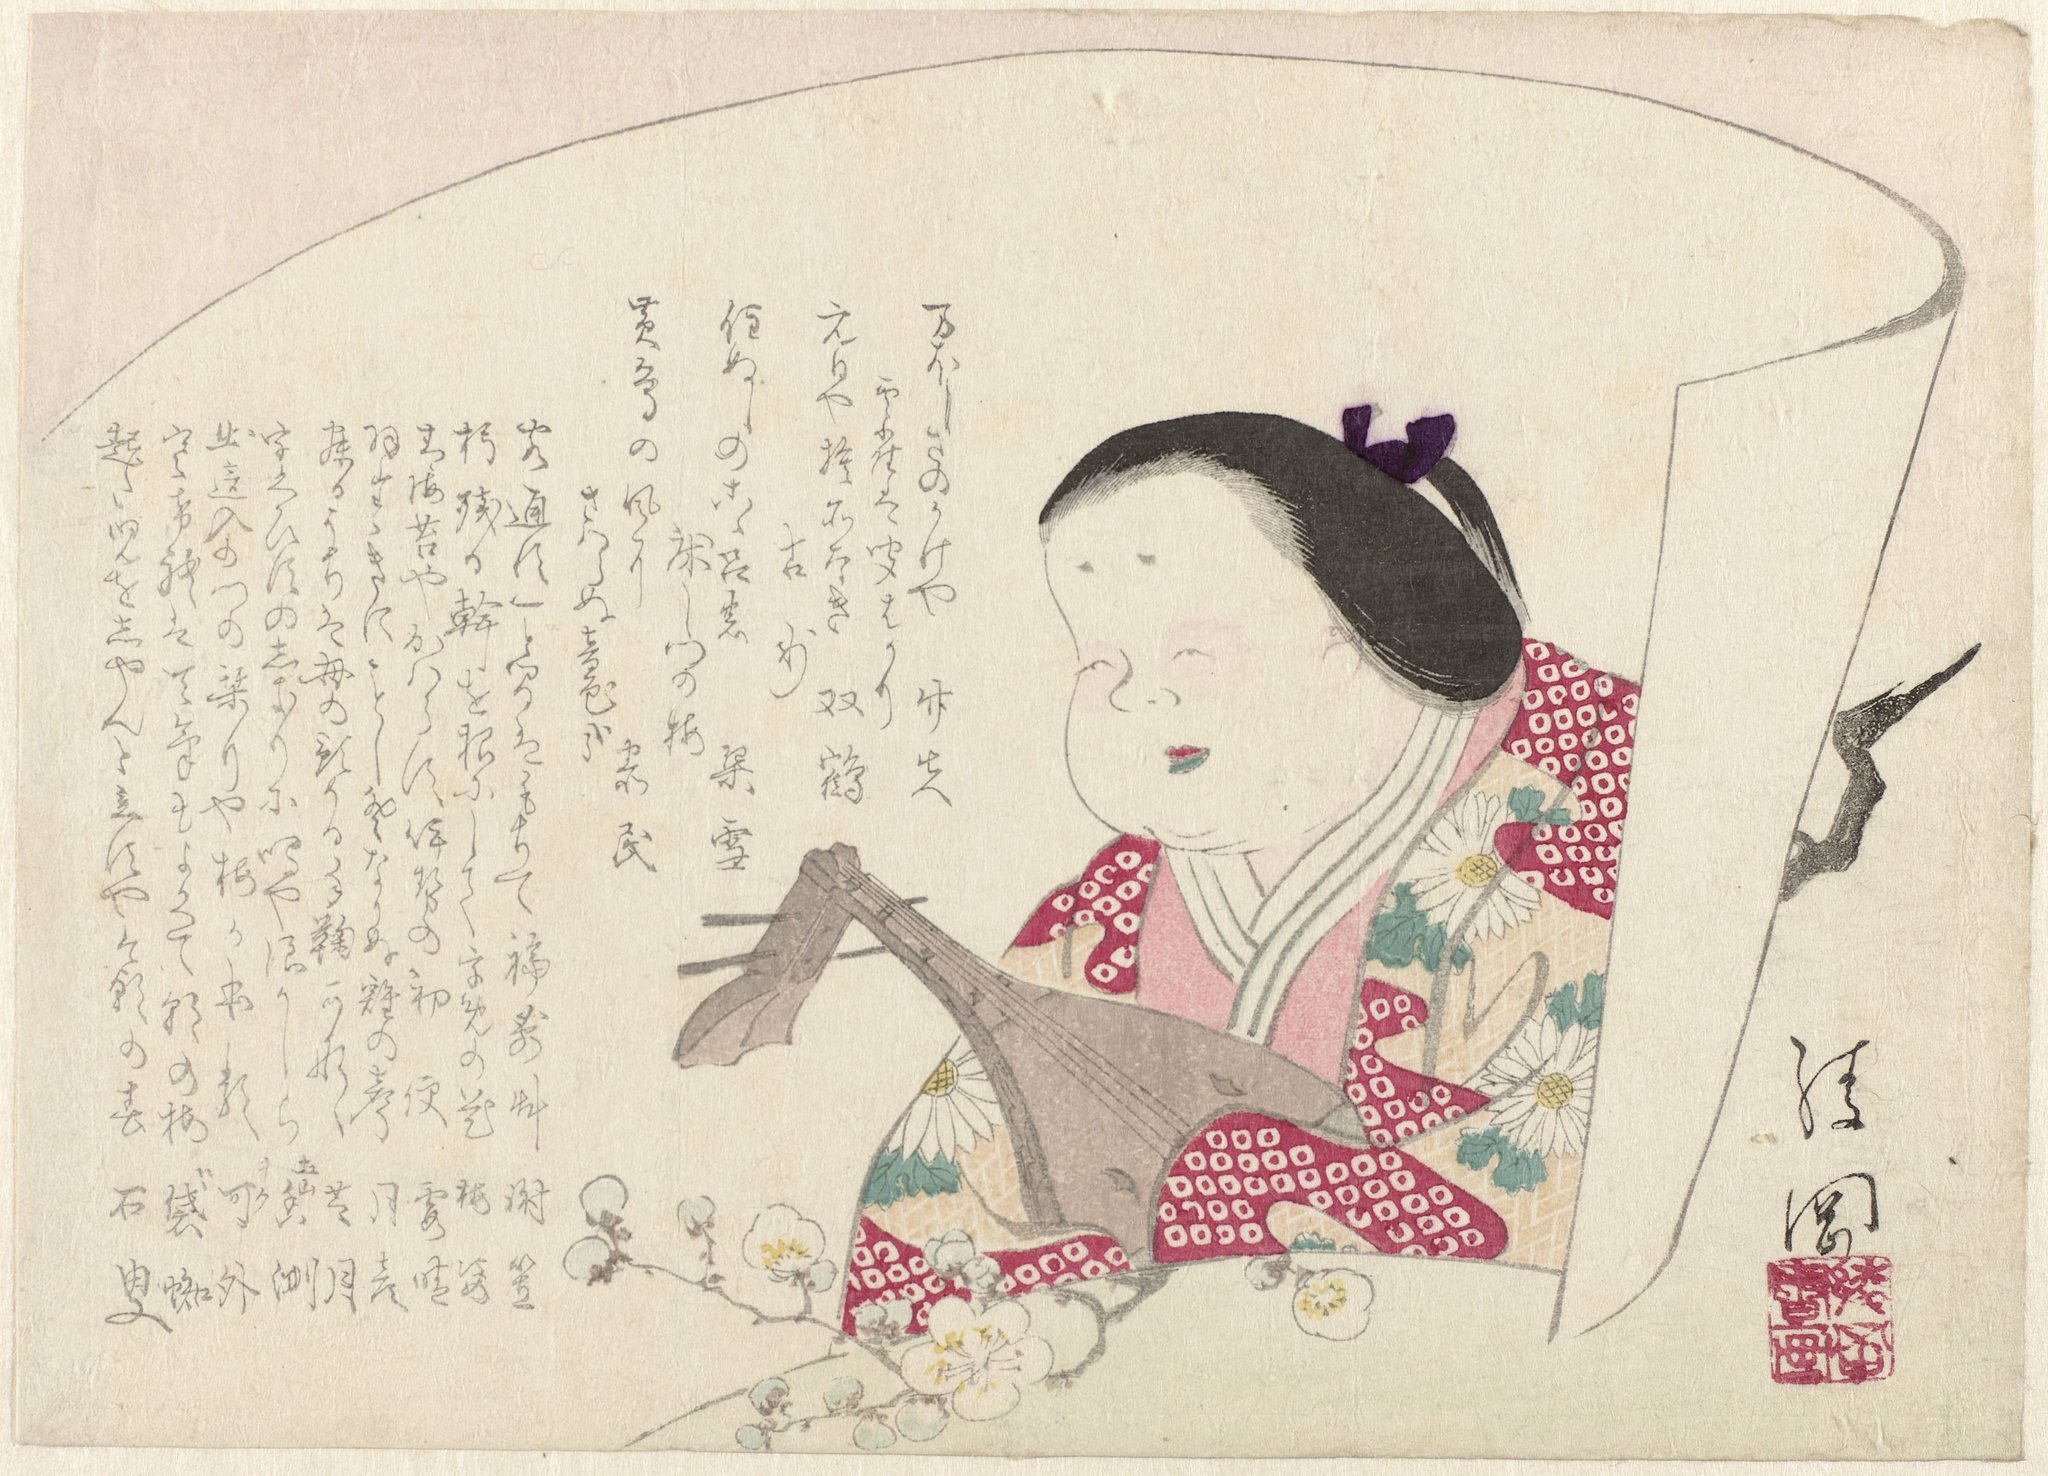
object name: print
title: Vrouw met biwa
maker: ayaoka yûshin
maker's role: print maker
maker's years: 1846-1910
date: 1856-1910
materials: paper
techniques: woodcut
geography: japan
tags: string instruments (plucked)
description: Een surimono is een luxe uitgevoerde prent waarop beeld met één of meerdere gedichten gecombineerd is. Bij het drukken van een surimono werd vaak gebruik gemaakt van dikker papier, blinddruk en metaal pigmenten, zoals koper- en zilverpoeder. De prenten werden vaak in opdracht van dichters gemaakt en als exclusief geschenk aan vrienden en relaties gegeven.